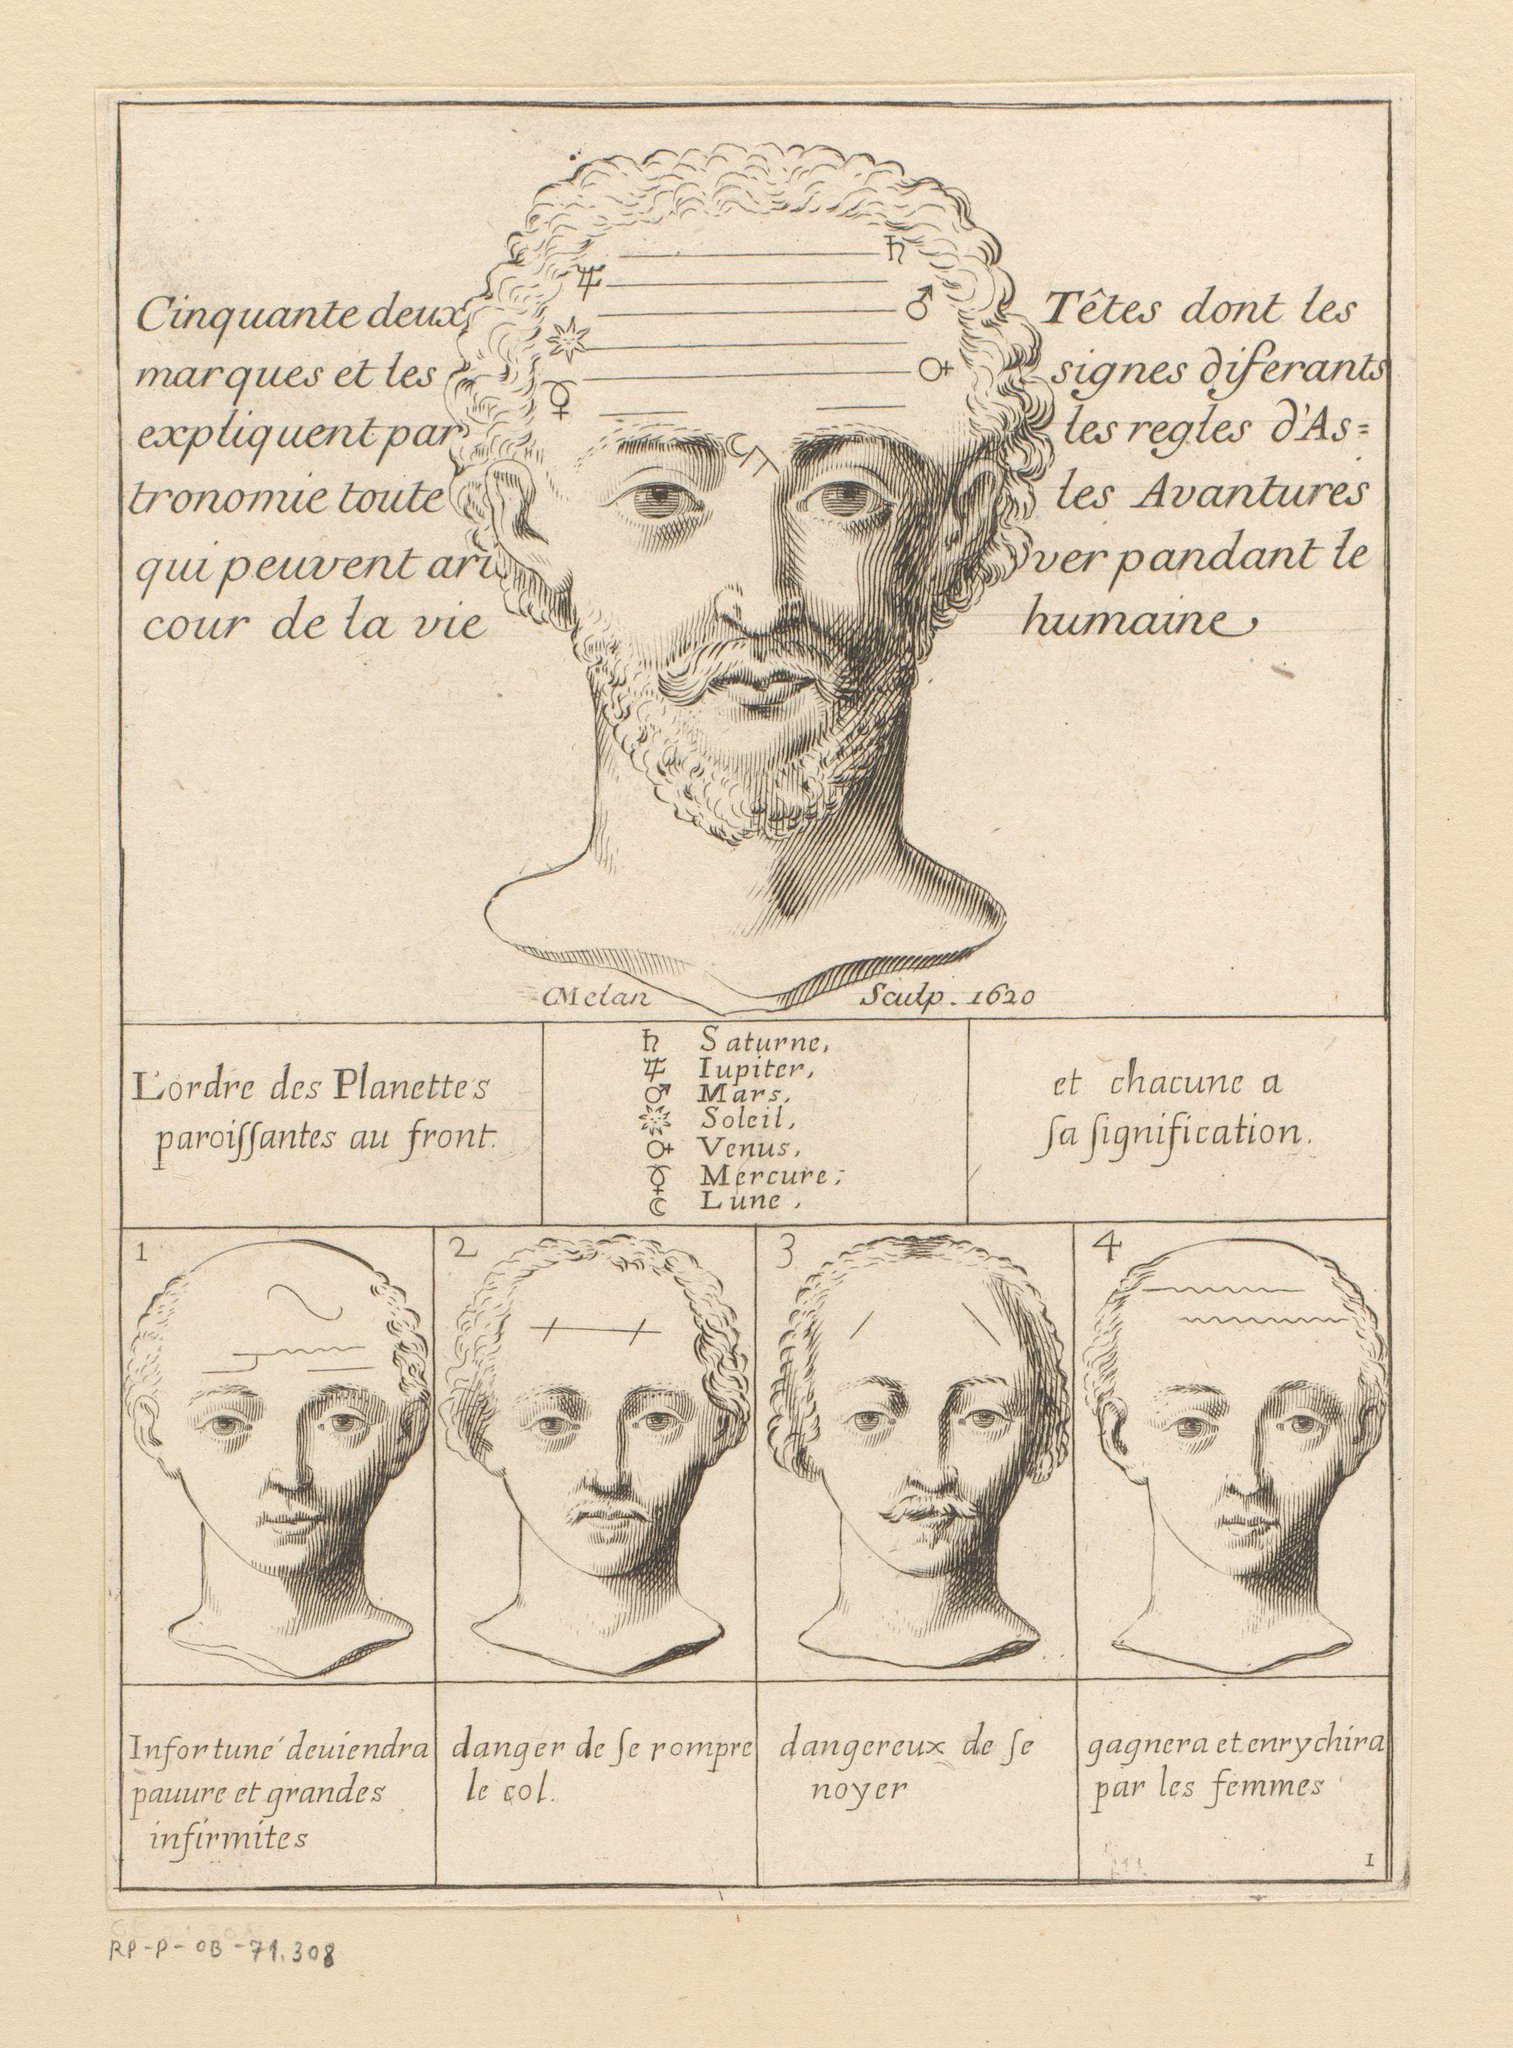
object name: titelprent, frontispice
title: Titelprent met vijf hoofden en astrologische tekens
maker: claude mellan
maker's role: draughtsman, print maker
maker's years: 1598-1688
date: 1620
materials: paper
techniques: engraving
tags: face, astrological signs and symbols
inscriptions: collector's mark: Lugt 240